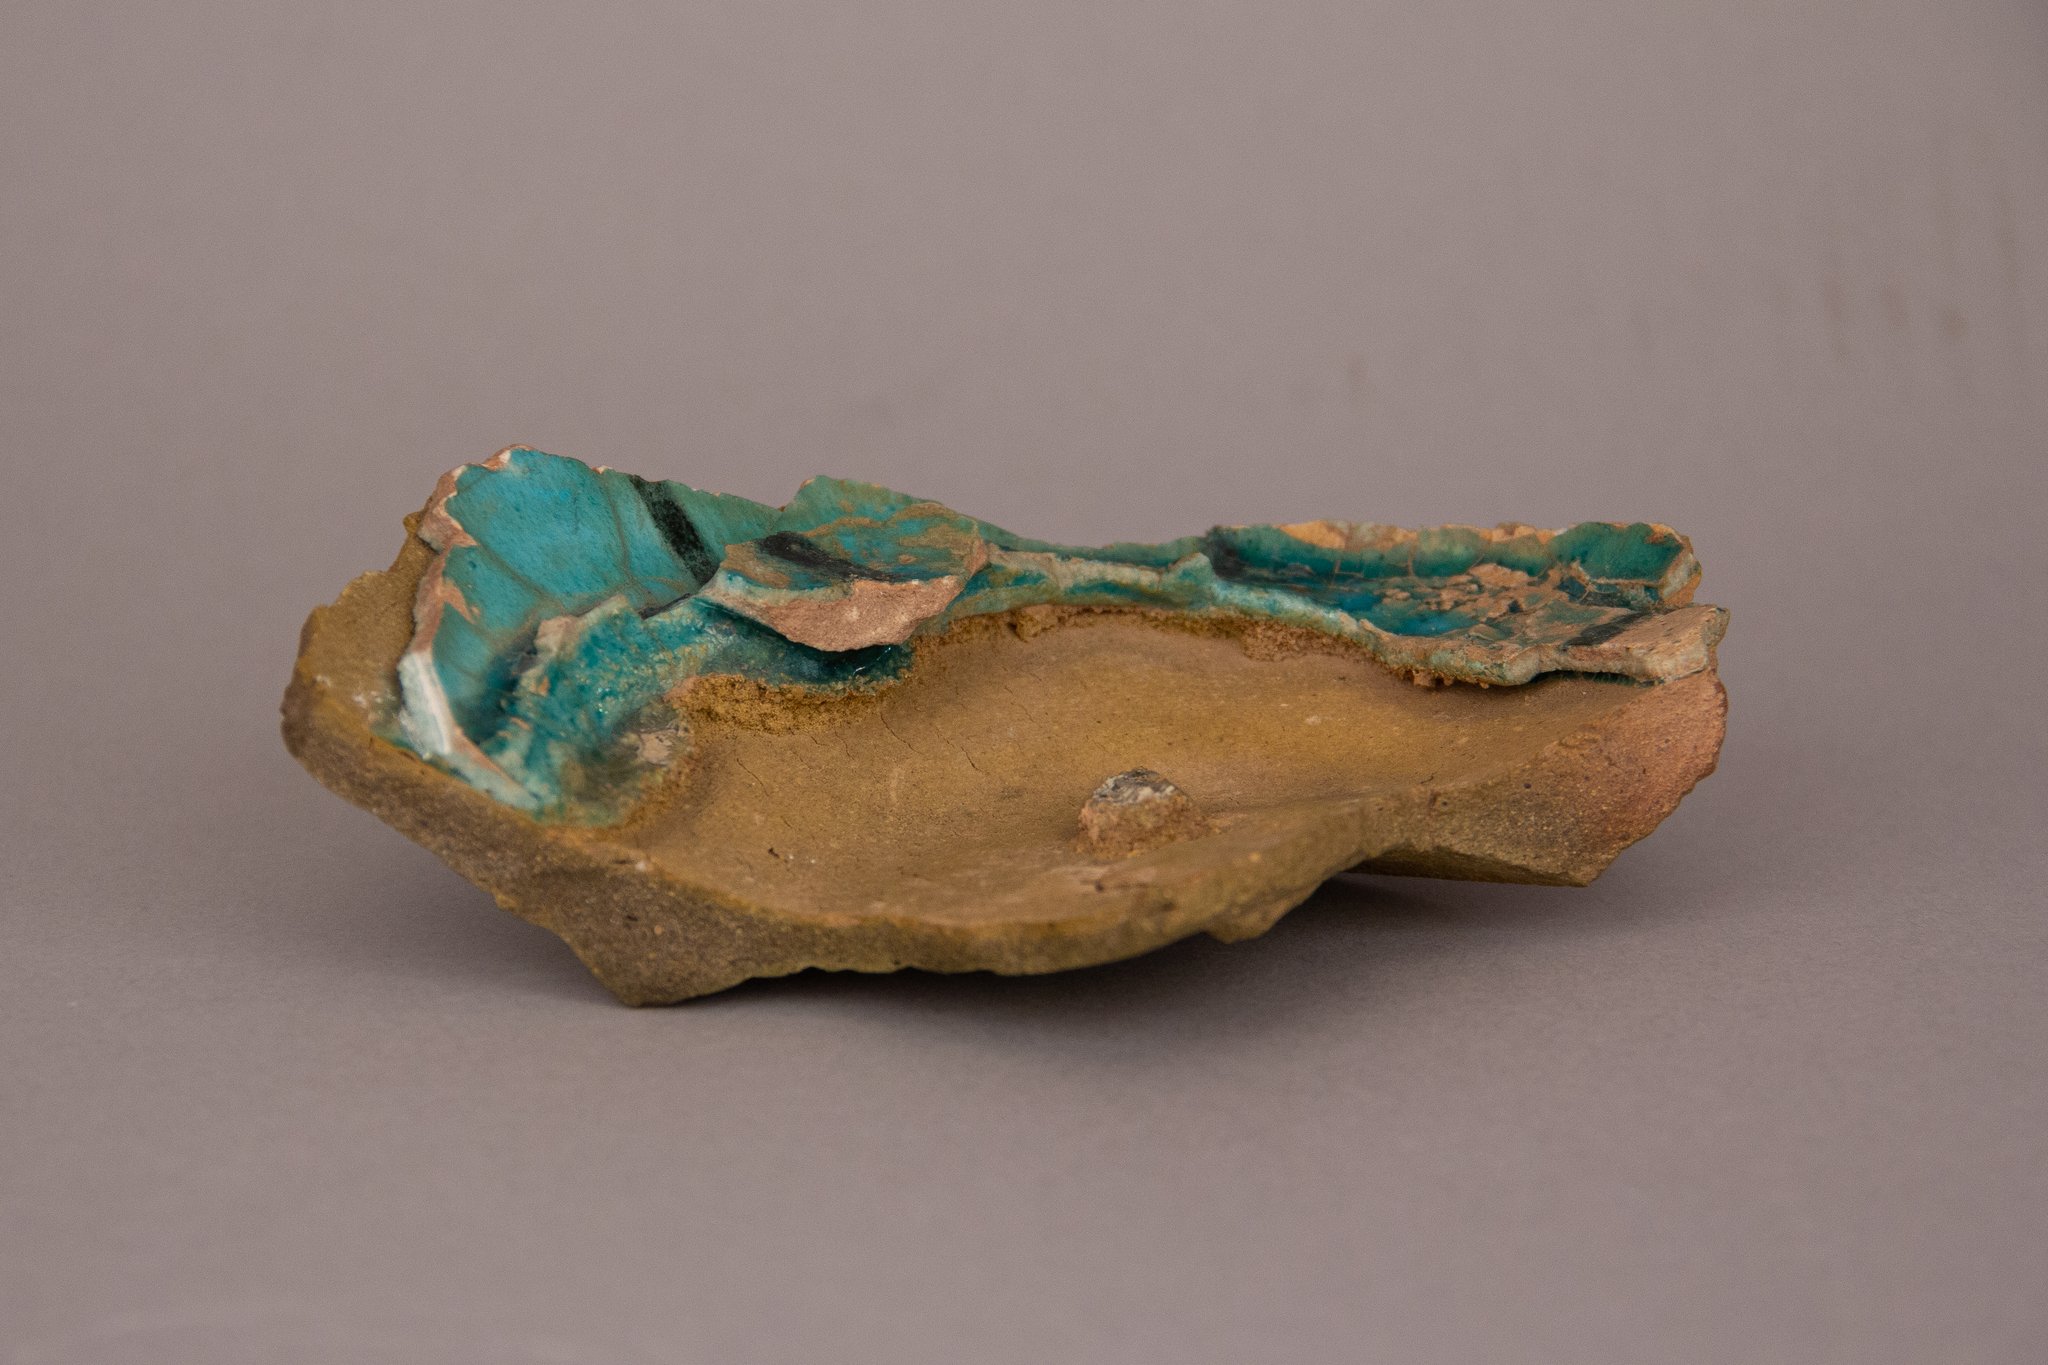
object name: fragment of a waster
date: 1001-1200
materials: earthenware, glaze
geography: iran